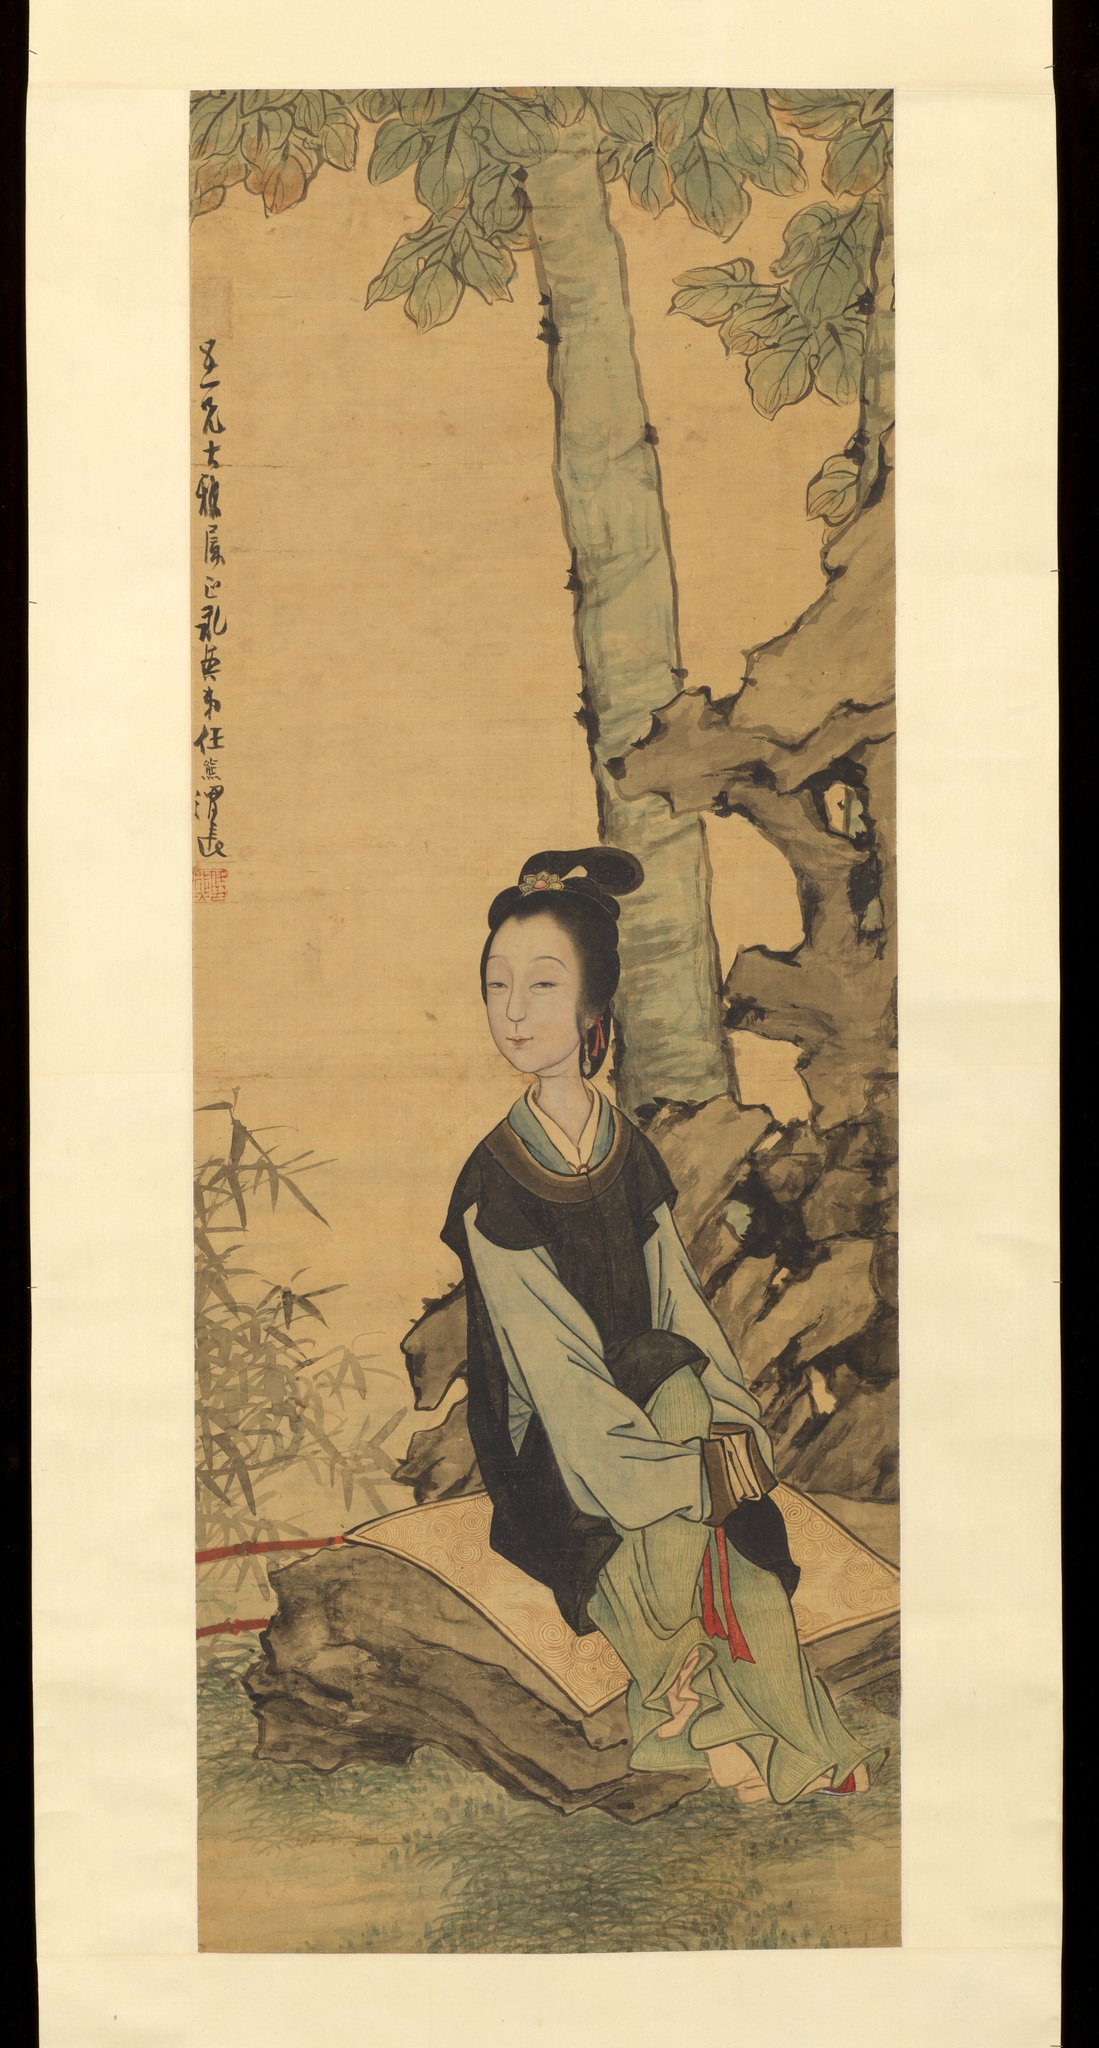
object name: hanging scroll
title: Woman in a garden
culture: chinese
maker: ren xiong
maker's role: artist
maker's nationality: chinese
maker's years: 1823-1857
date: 1834-1866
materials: ink, silk